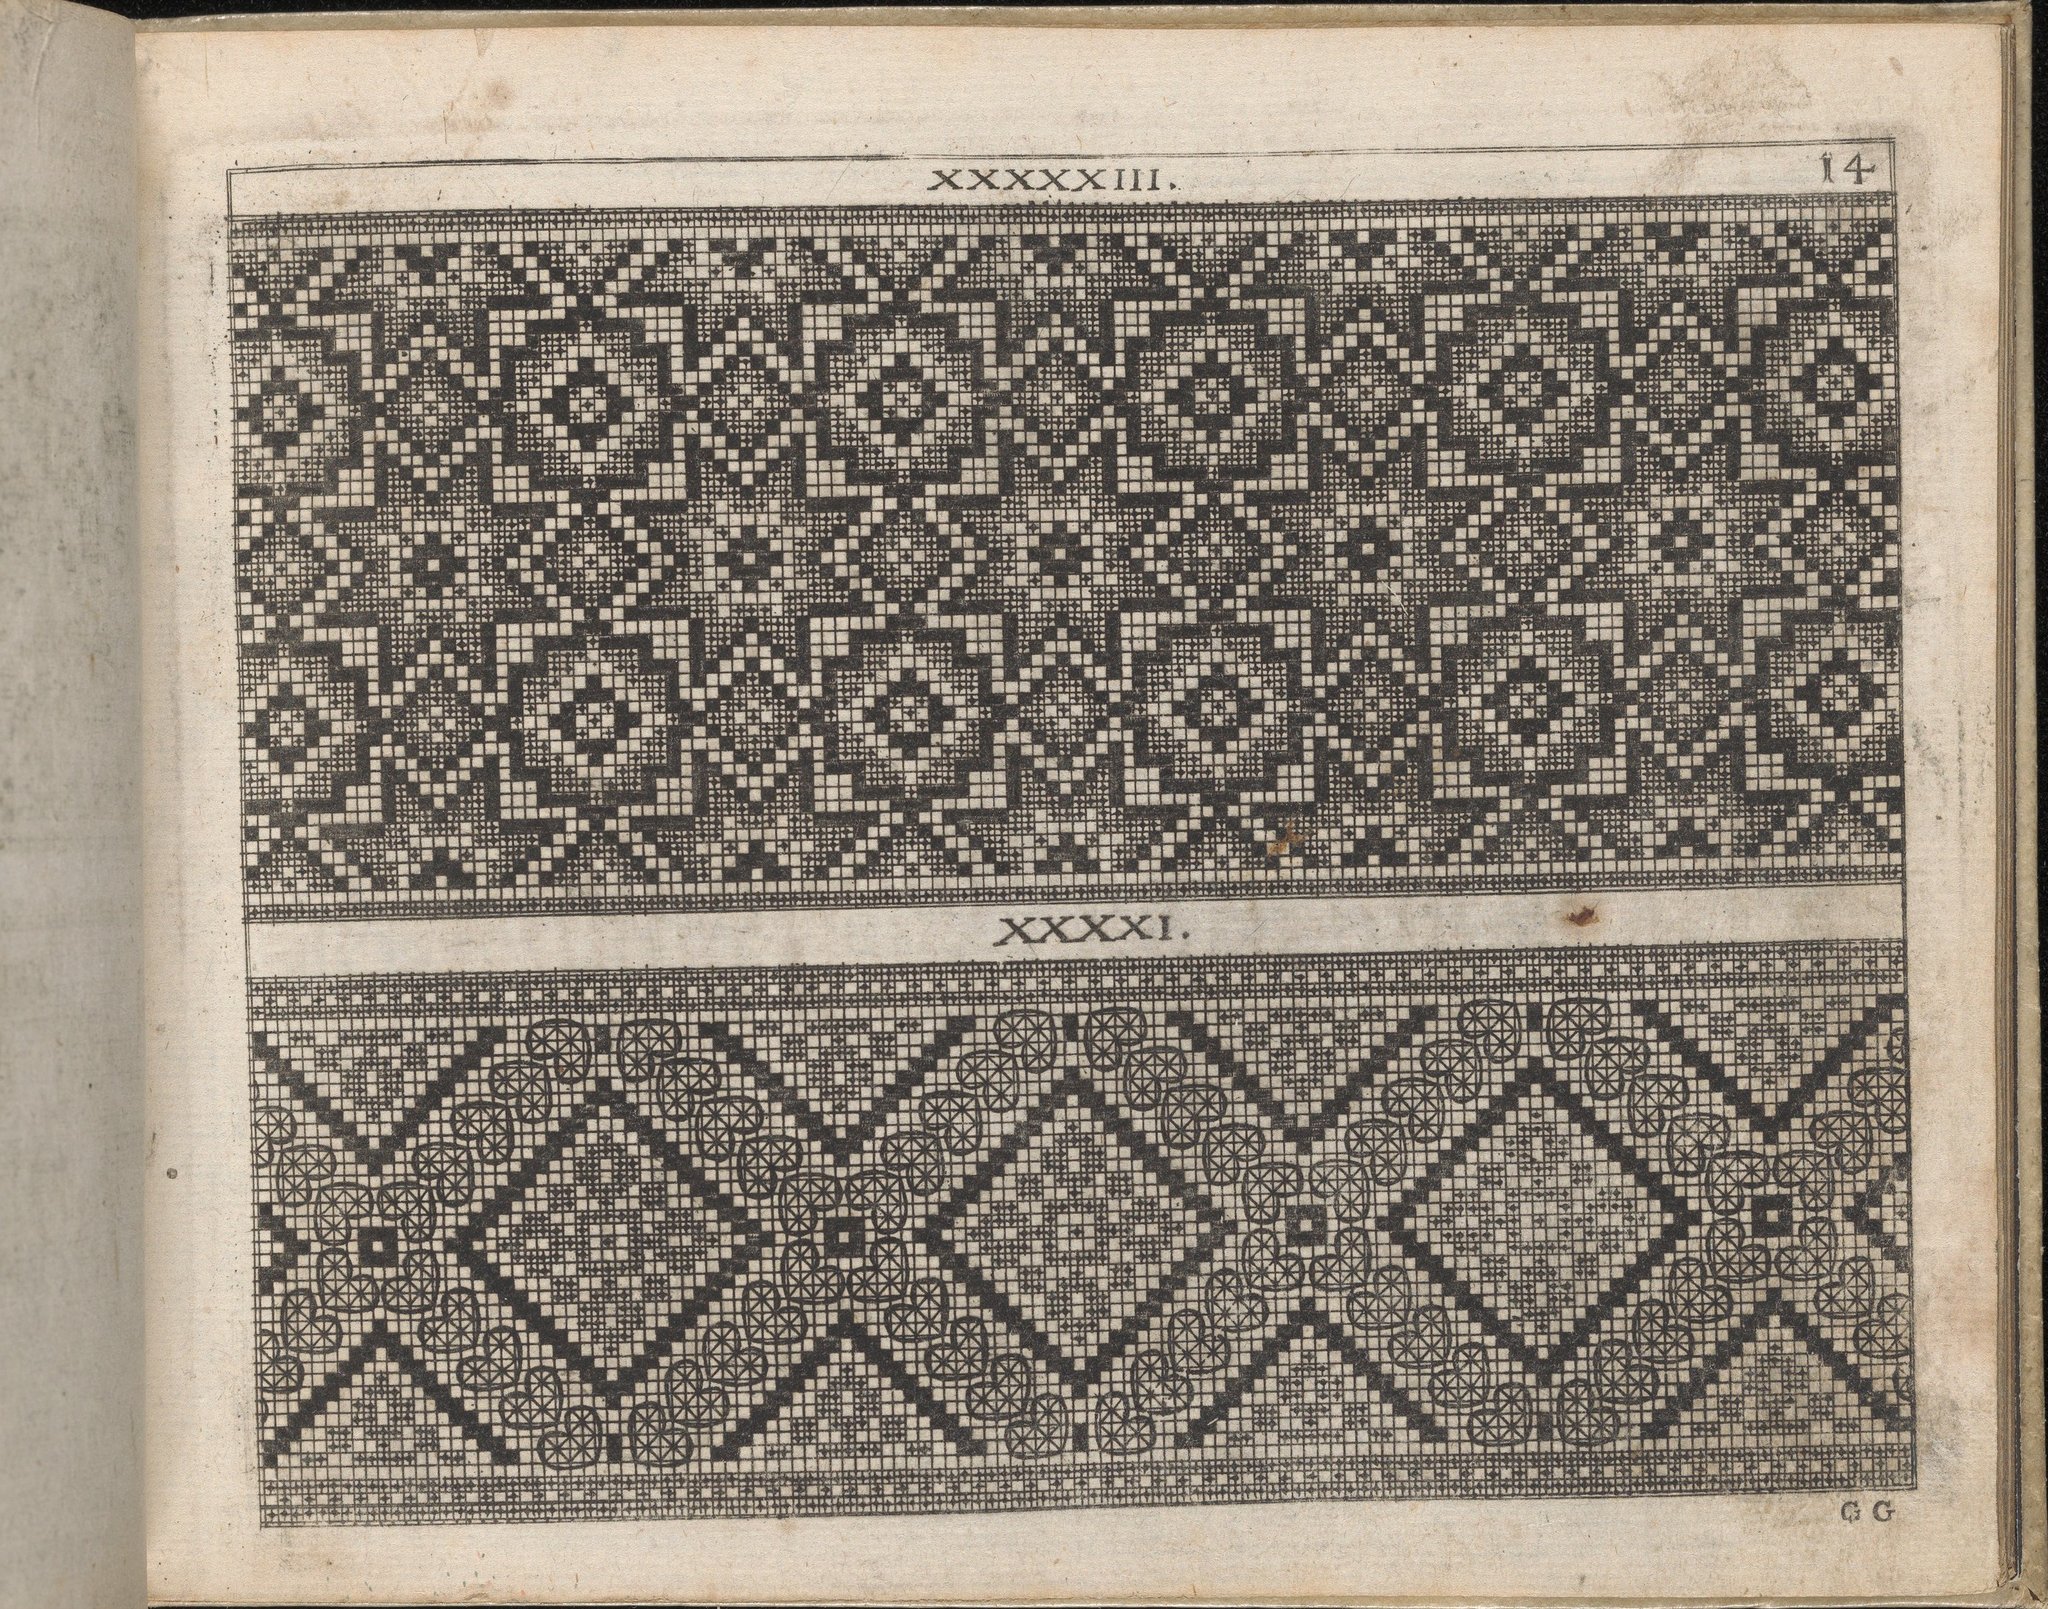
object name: book print ornament architecture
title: Newes Modelbuch in Kupffer (Page 23r)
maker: johann sibmacher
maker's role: artist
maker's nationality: german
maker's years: 1590-1611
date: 1604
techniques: etching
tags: ornament